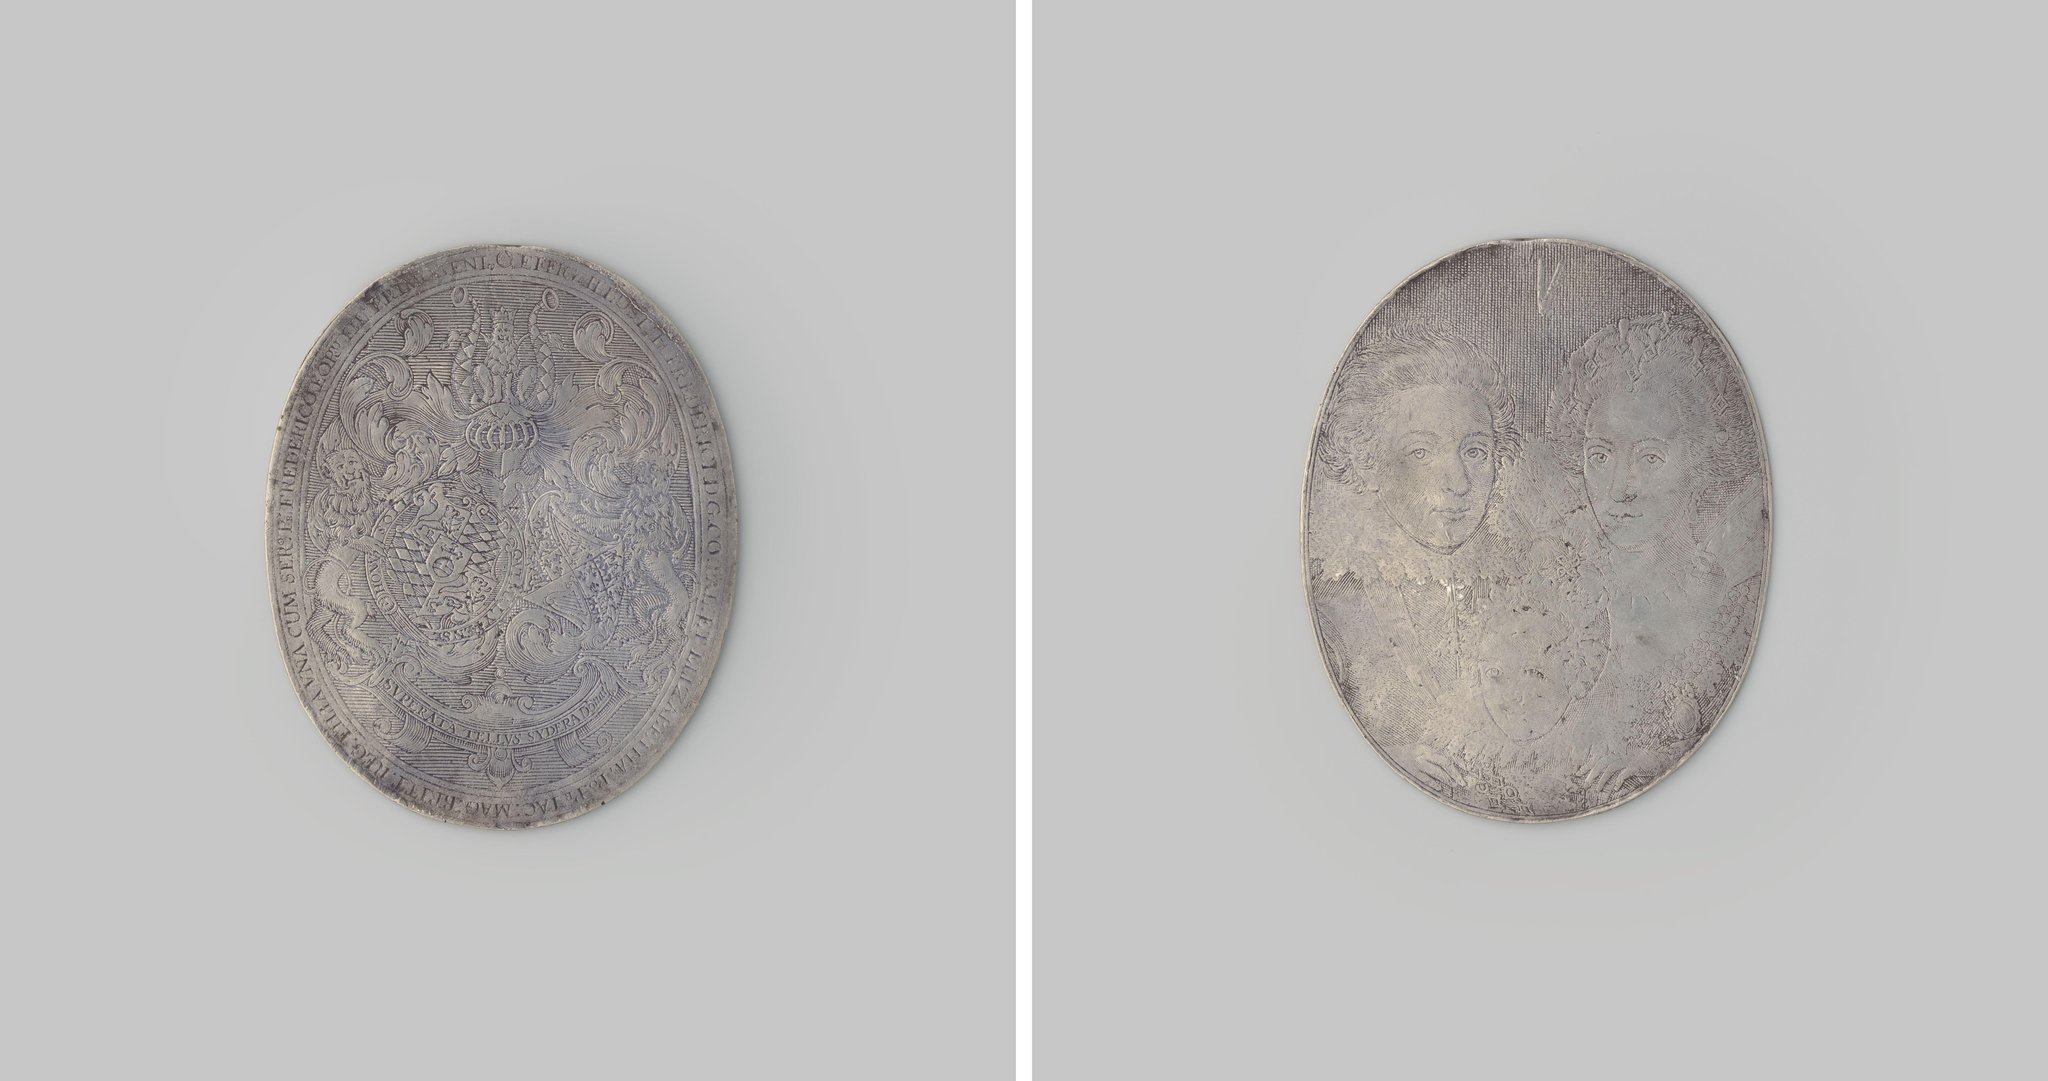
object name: medal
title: Frederick V (1596-1632), Elizabeth Stuart (1596-1662) and their Son Frederick Henry (1614-1629)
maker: simon van de passe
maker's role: print maker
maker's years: 1595-1647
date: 1616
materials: tin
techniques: casting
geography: london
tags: amberg, frederik v (keurvorst van de palts, koning van bohemen), london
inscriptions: monogram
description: Most coins have a side with a portrait, usually of a ruler. In addition, portrait medals have also always been made, primarily to honour, commemorate, or glorify an important event or person. They were often intended for a general public. Some were destined to be family heirlooms. In any case, the medallists tried to make the likenesses as realistic as possible. That is why they are considered a separate genre.